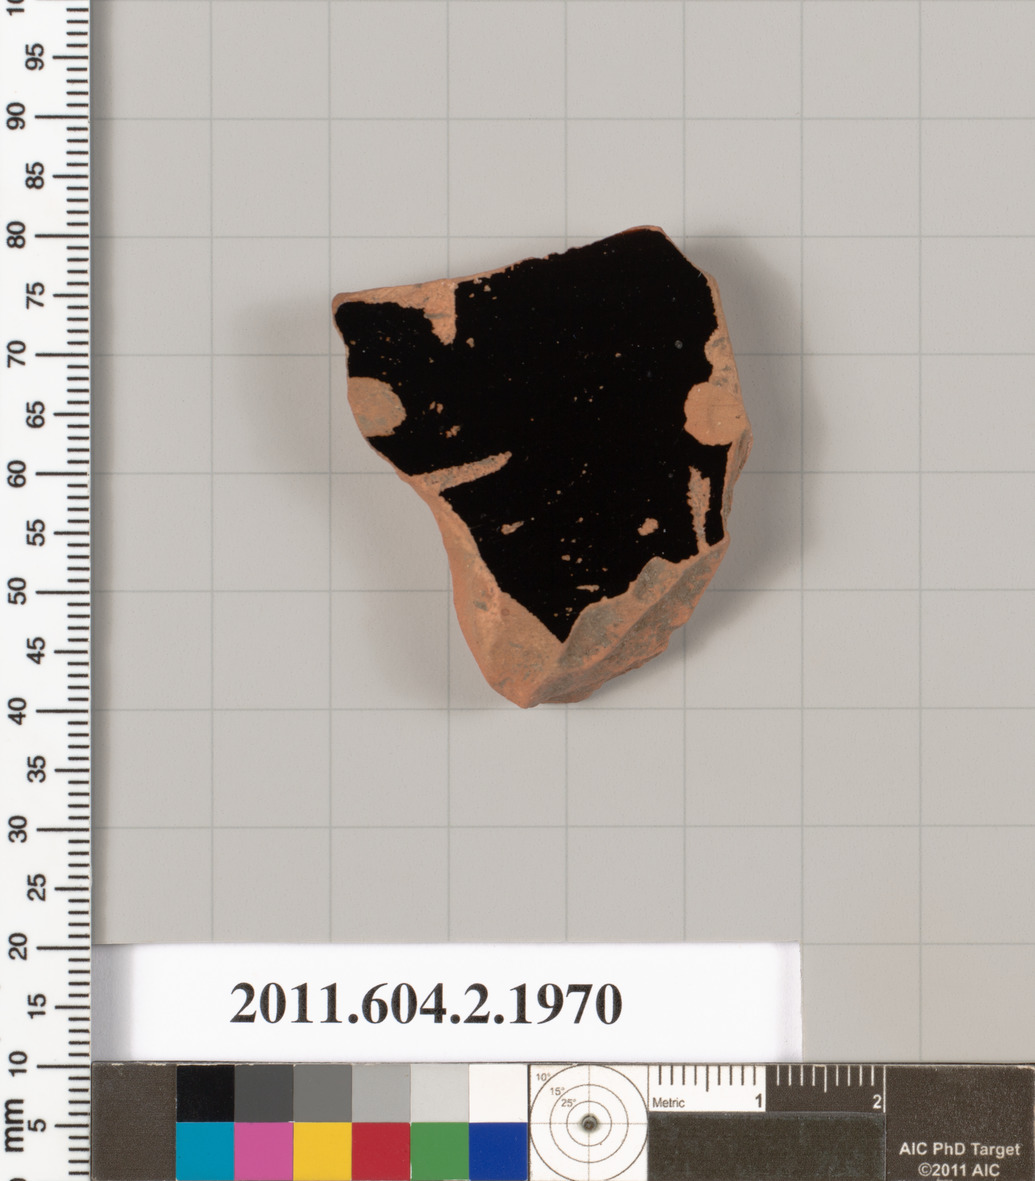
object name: krater fragment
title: Terracotta fragment of a krater (bowl for mixing wine and water)?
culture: greek, attic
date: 475-451 BCE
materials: terracotta